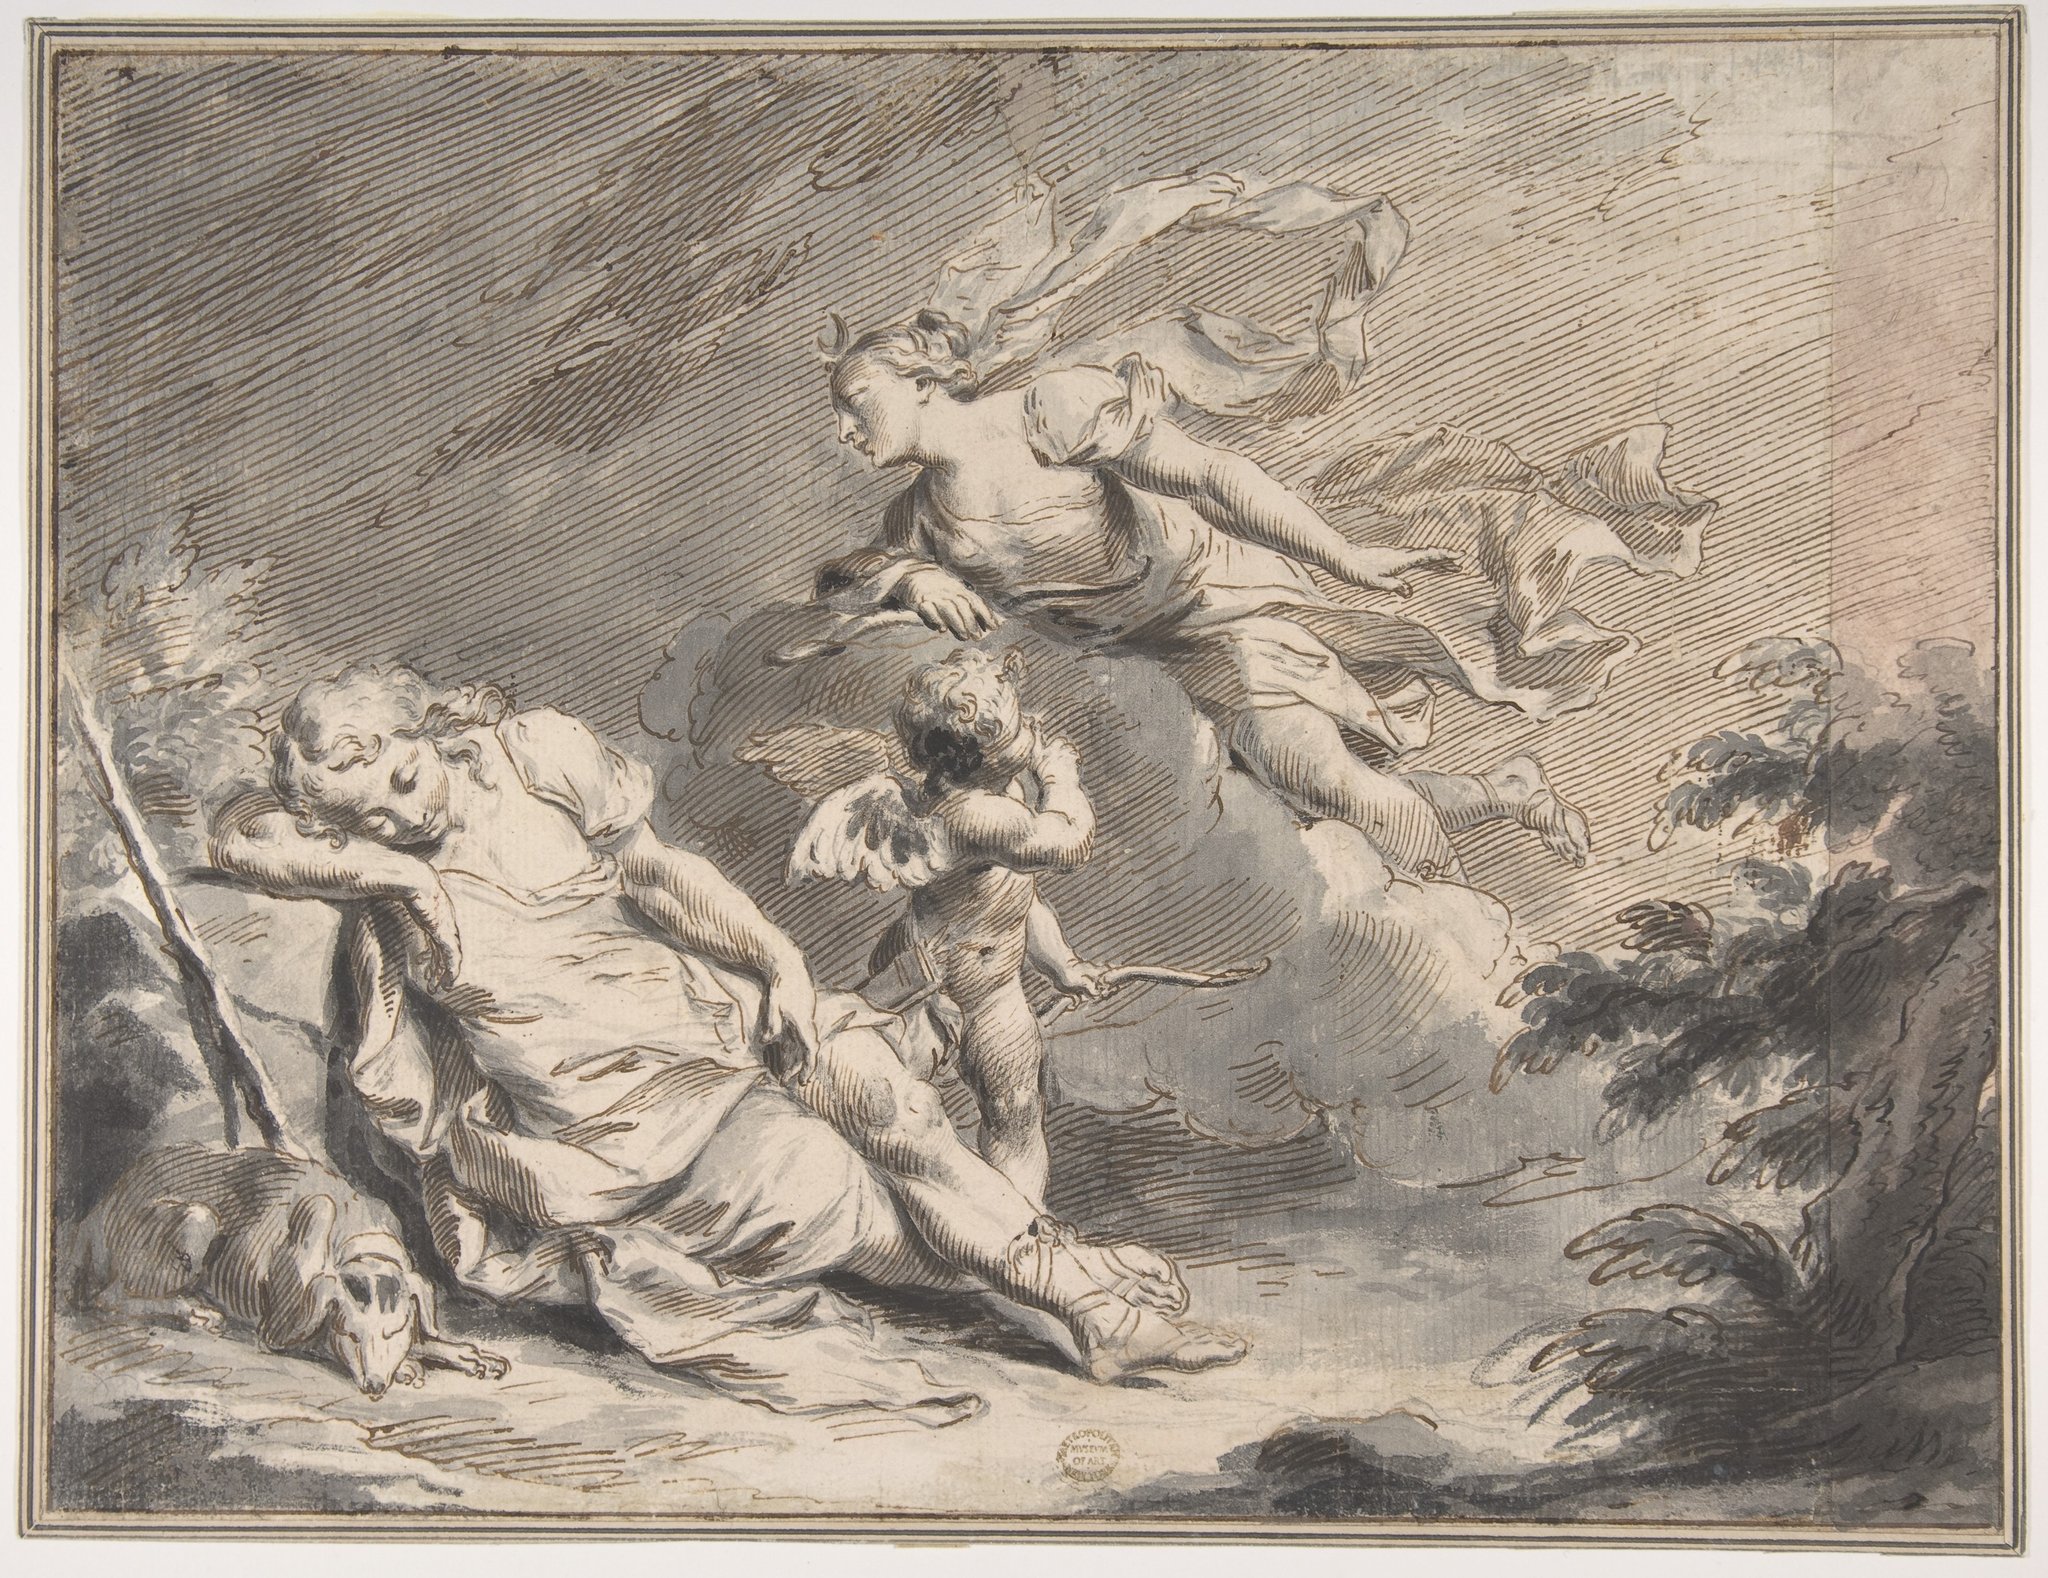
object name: drawing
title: Diana Visiting the Sleeping Endymion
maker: pietro antonio novelli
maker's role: artist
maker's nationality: italian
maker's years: 1729-1804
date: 1729-1804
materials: chalk, ink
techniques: brush, pen, wash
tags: sleeping,cupid,diana,dogs